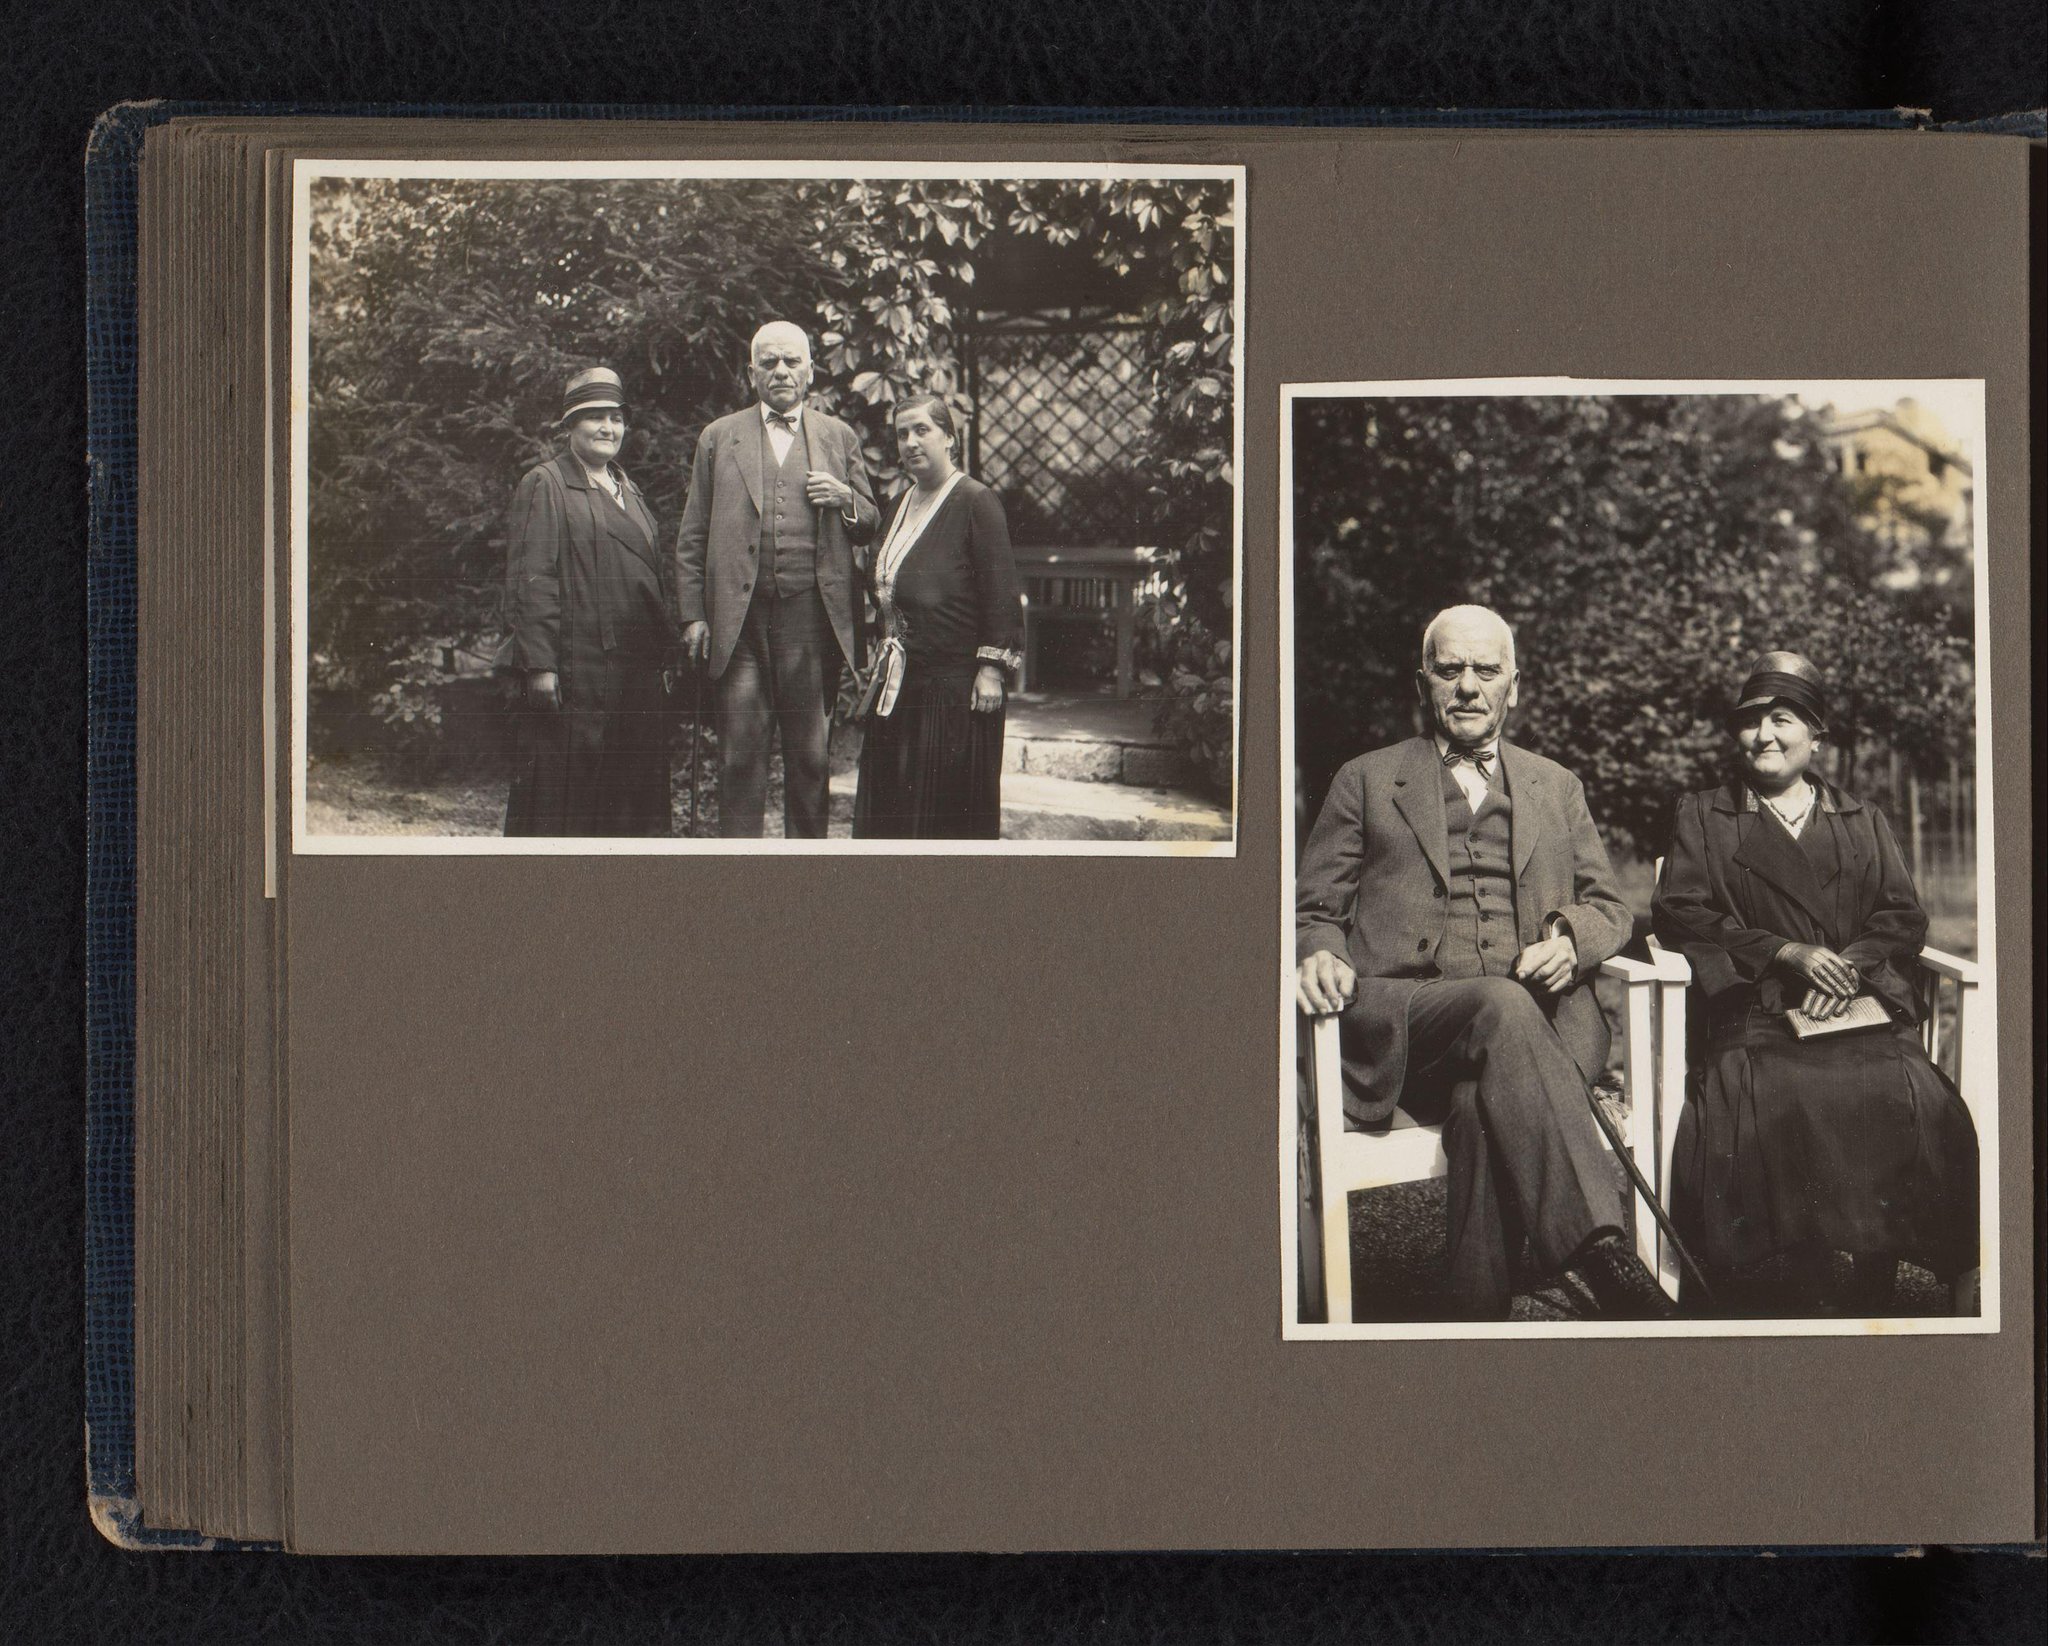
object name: photograph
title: Meir Wachenheimer en zijn vrouw Mathilde Wachenheimer-Wertheimer op bezoek bij hun zoon Eugen Wachenheimer en schoondochter Else Wachenheimer-Moos, vermoedelijk 1928, vermoedelijk Neurenberg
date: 1928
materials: paper, photographic support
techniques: gelatin silver print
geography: nuremberg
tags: eugen wachenheimer, else wachenheimer-moos, family life at home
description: Albumblad bevat twee foto's van Meir Wachenheimer, Mathilde Wachenheimer-Wertheimer en Else Wachenheimer-Moos. Uit album half formaat, blauw kunstlederen omslag met koordbinding.